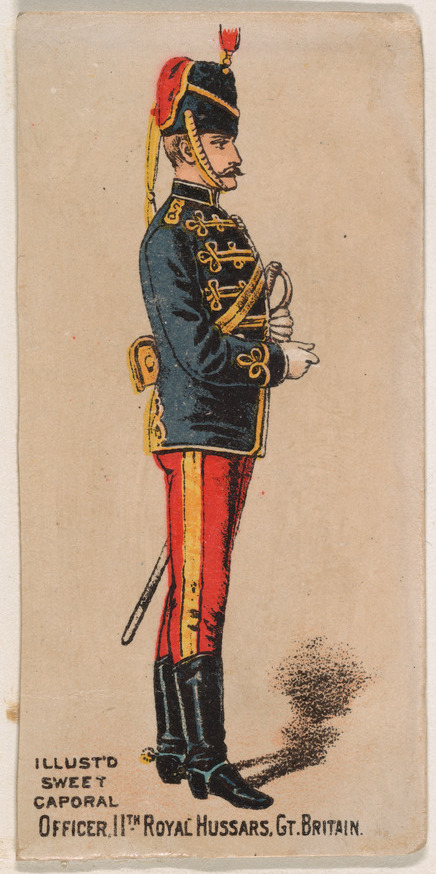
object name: print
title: Officer, 11th Royal Hussars, Great Britain, from the Military Series (N224) issued by Kinney Tobacco Company to promote Sweet Caporal Cigarettes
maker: kinney brothers tobacco company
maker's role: publisher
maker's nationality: american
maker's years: 1869-2011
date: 1888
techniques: color lithograph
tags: soldiers,men,profiles